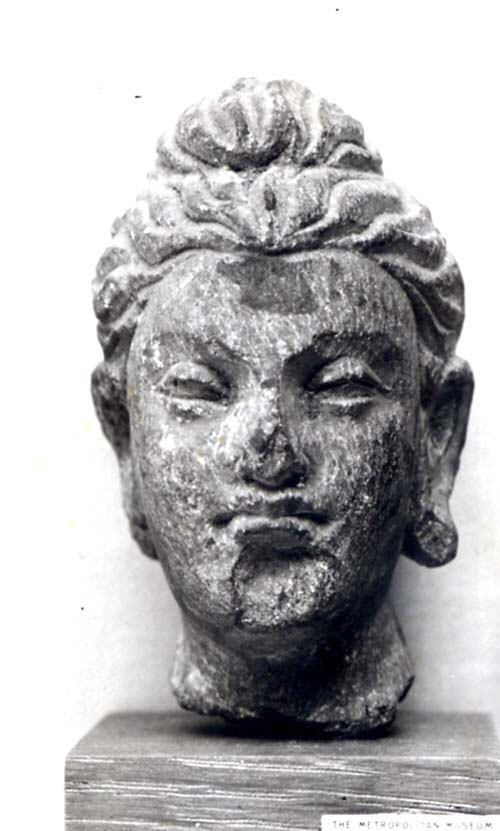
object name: head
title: Head of Buddha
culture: gandhara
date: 201-500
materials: stone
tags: gandhara,heads,buddha